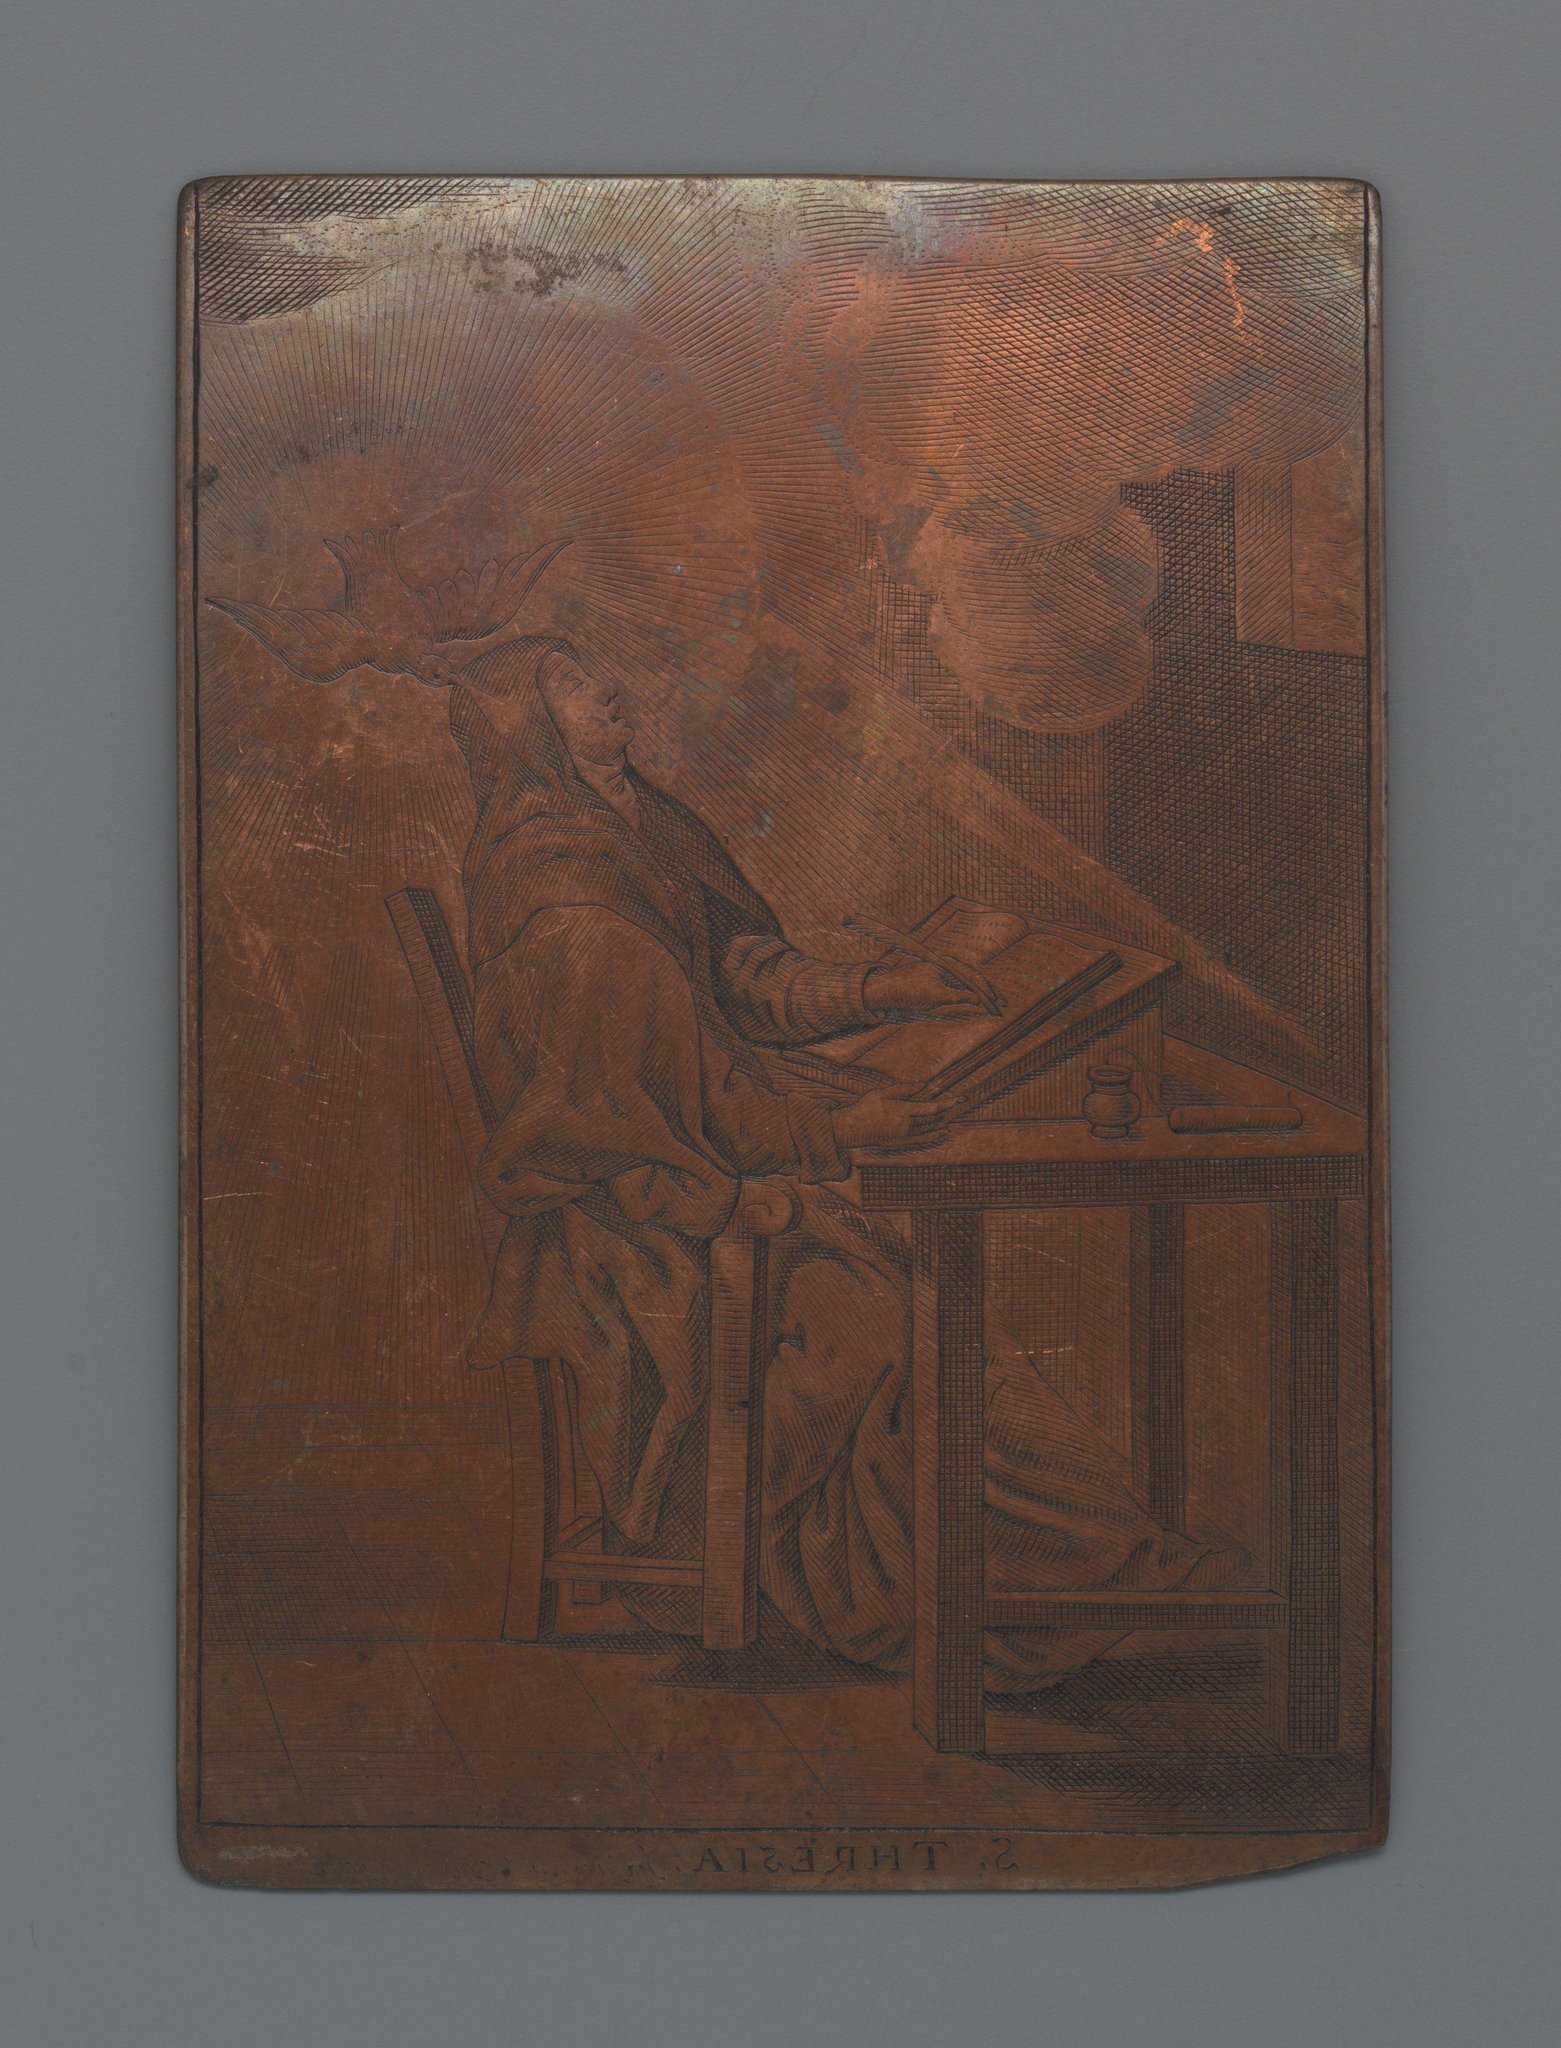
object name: copper plate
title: Koperplaat met de heilige Theresa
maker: Anonymous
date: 1650-1700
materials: copper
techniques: engraving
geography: antwerp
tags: the foundress of the reformed (discalced) carmelites, t(h)eres(i)a of avila; possible attributes: angel, arrow, dove, heart (flaming or pierced by an arrow)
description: De platen (RP-D-2014-9-1 t/m 35) zijn vrijwel allemaal vervaardigd door anonieme graveurs werkend voor de Antwerpse uitgevers Cornelis Galle, Frans Huberti (Huybrechts), Theodor van Merlen II en Michel Bunel. Vermoedelijk zijn ze uiteindelijk beland in één fonds, wellicht dat van Michel Bunel (1670-1739) en warden sindsdien bij elkaar bewaard. Afwijkend is de grote prent van Henry Verbruggen met een weergave van de Preekstoel uit de St. Gudule-kerk te Brussel. Twee prenten zijn verpakt in een oude afdruk van de prent, zoals te doen gebruikelijk in uitgeverijen (vergl. oude platen in Museum Plantijn Moretus, Antwerpen). Van 8 platen heeft de vorige eigenaar afdrukken laten maken op modern papier.